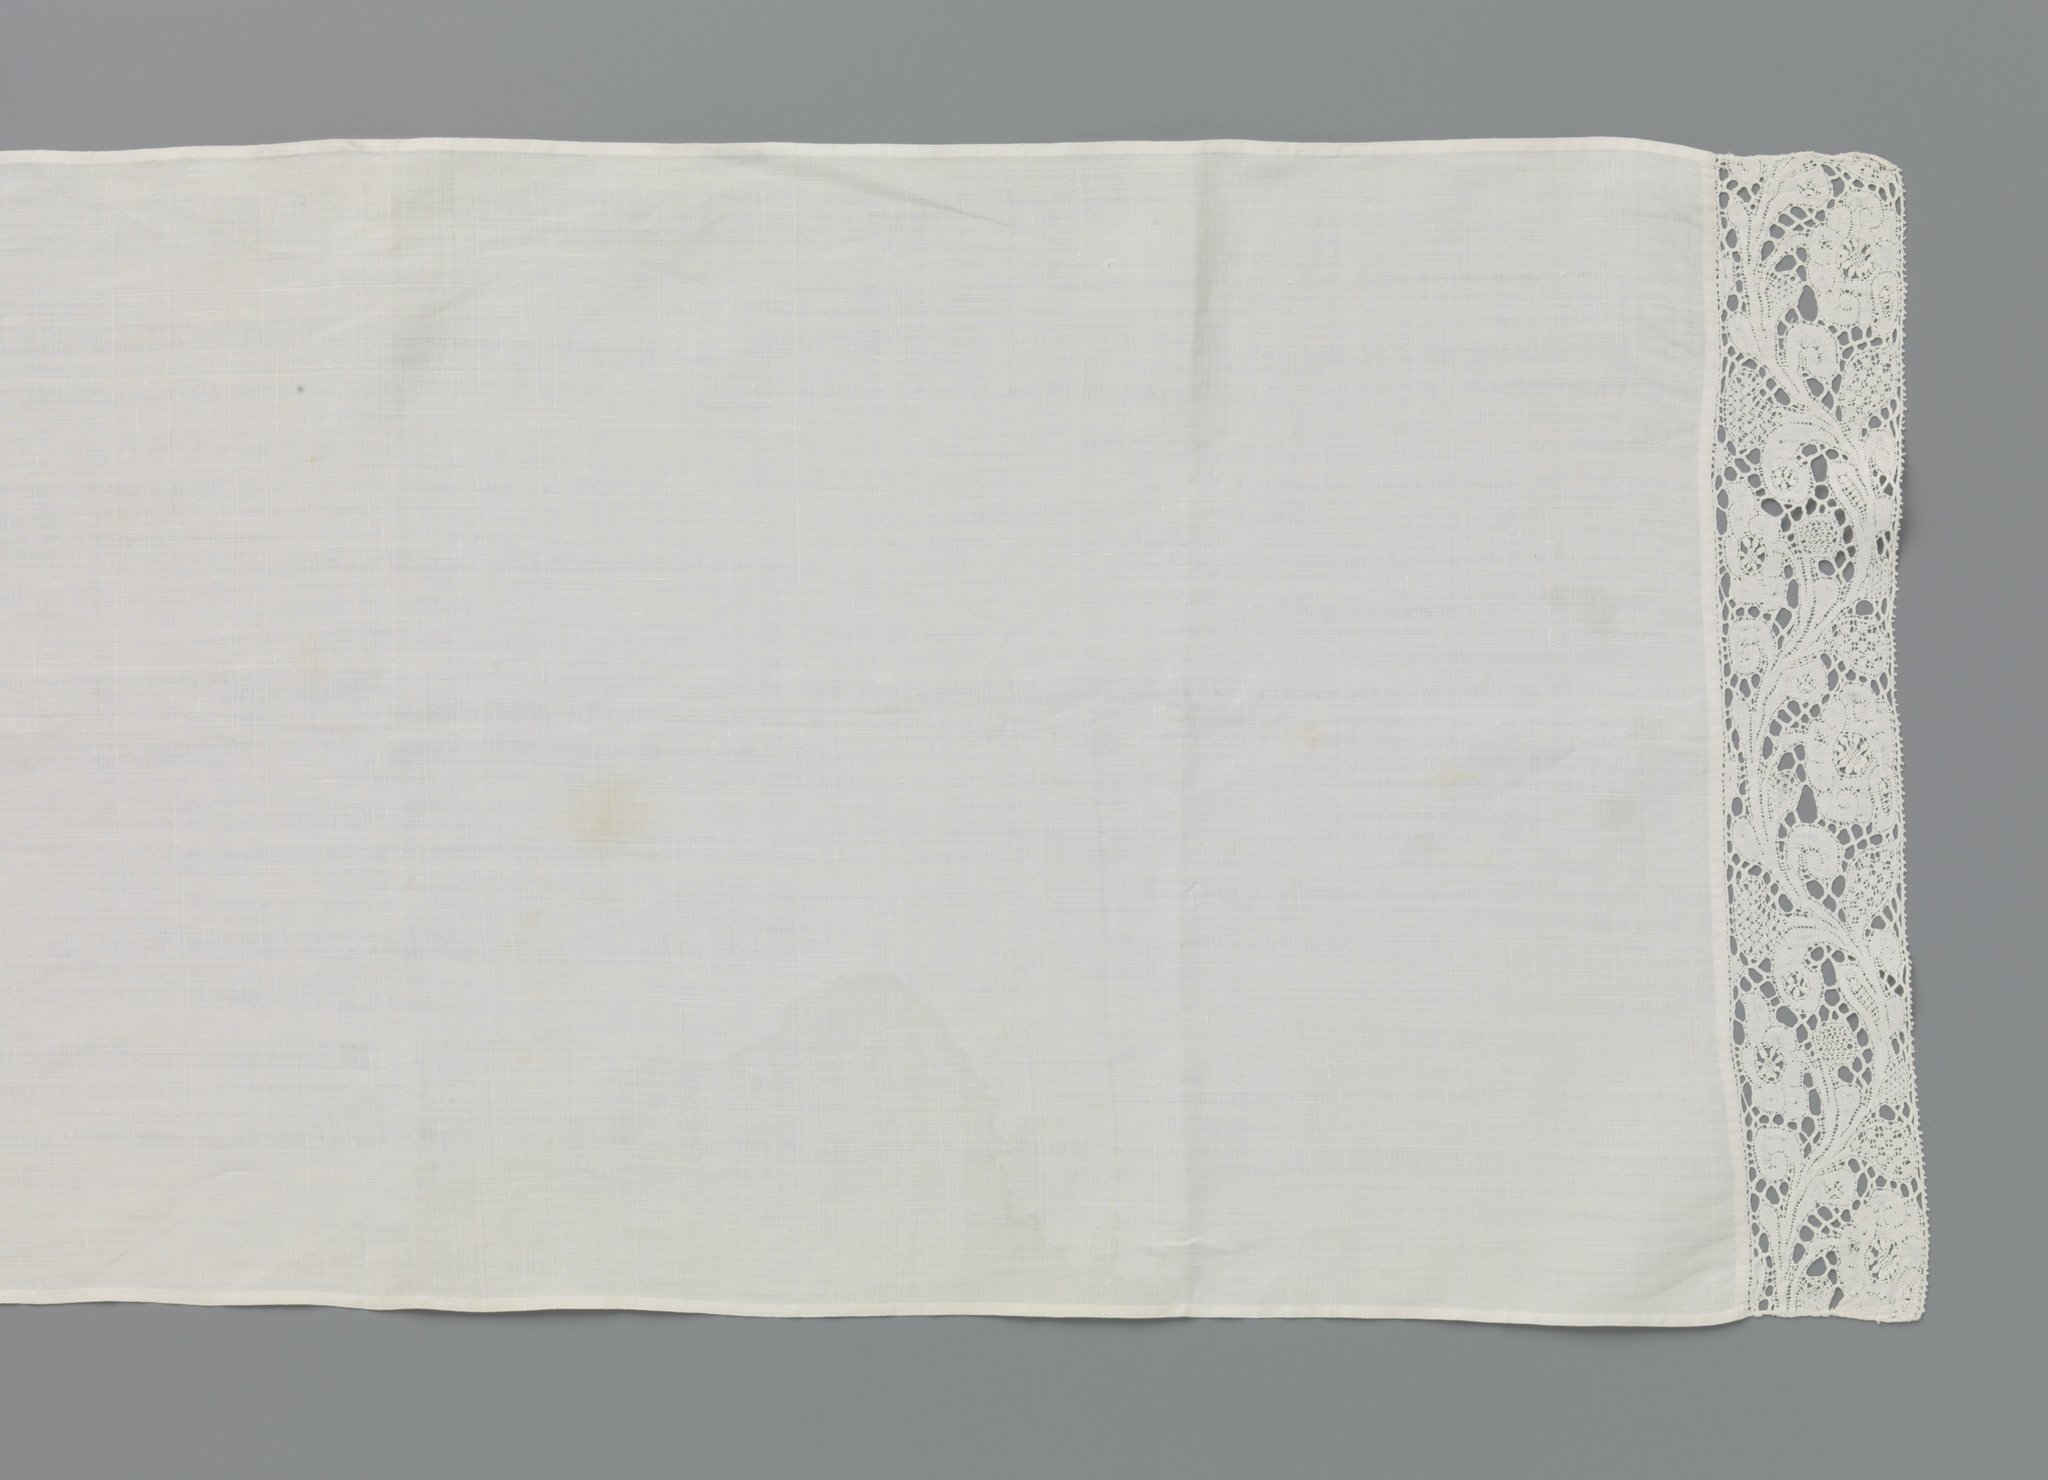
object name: table runner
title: Linnen loper met aan de uiteinden randen van kloskant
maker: Anonymous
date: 1675-1699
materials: linen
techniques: lace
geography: northern netherlands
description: Linnen loper met aan de korte kanten randen van kloskant, Antwerpse kant. Het zich herhalende en doorlopende kantpatroon bestaat uit een regelmatig golvende bladrank met in elk golfdal een grote omhoog krullende rozetbloem en onder elke golftop een kleiner omlaag krullende rozetbloem. De bladeren hebben veel verschillende vormen en vullingen. De motieven zijn met elkaar verbonden door een vlechtengrond. En ze zijn gemaakt in linnenslag met opengewerkte randjes. In de bladeren zijn verschillende siergronden gebruikt, waaronder fijne en grovere sneeuwvlokkengronden. In de bloemharten zijn motiefjes gemaakt in vormslag. De rechte onderzijde van de stroken zijn afgewerkt met picots.